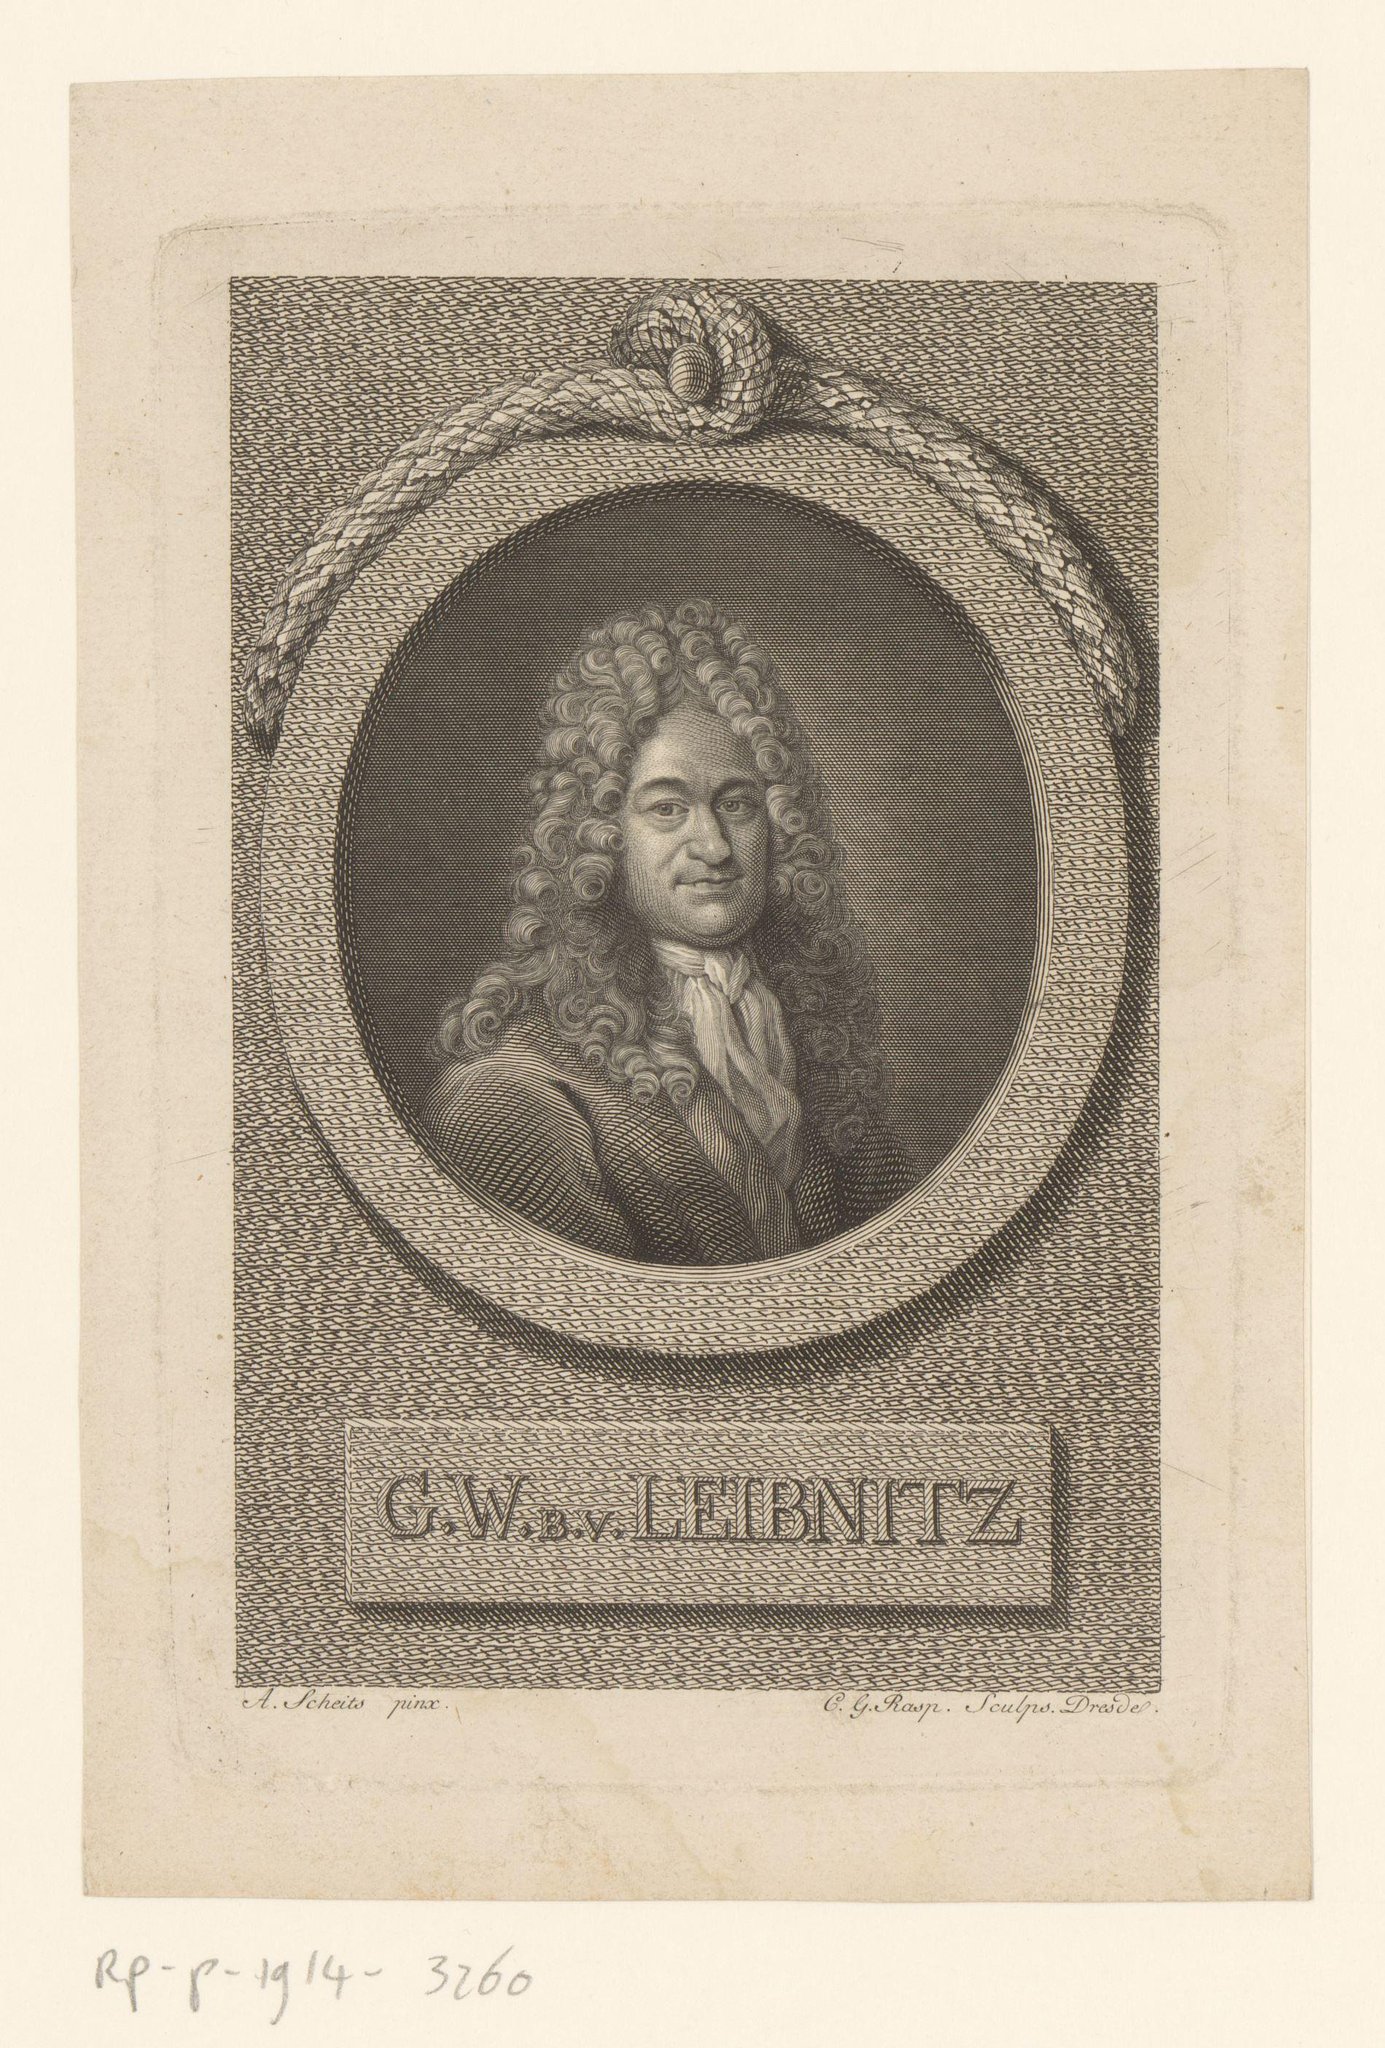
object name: print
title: Portret van Gottfried Wilhelm Leibniz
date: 1762-1807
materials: paper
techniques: engraving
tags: historical persons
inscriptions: collector's mark: Lugt 2228